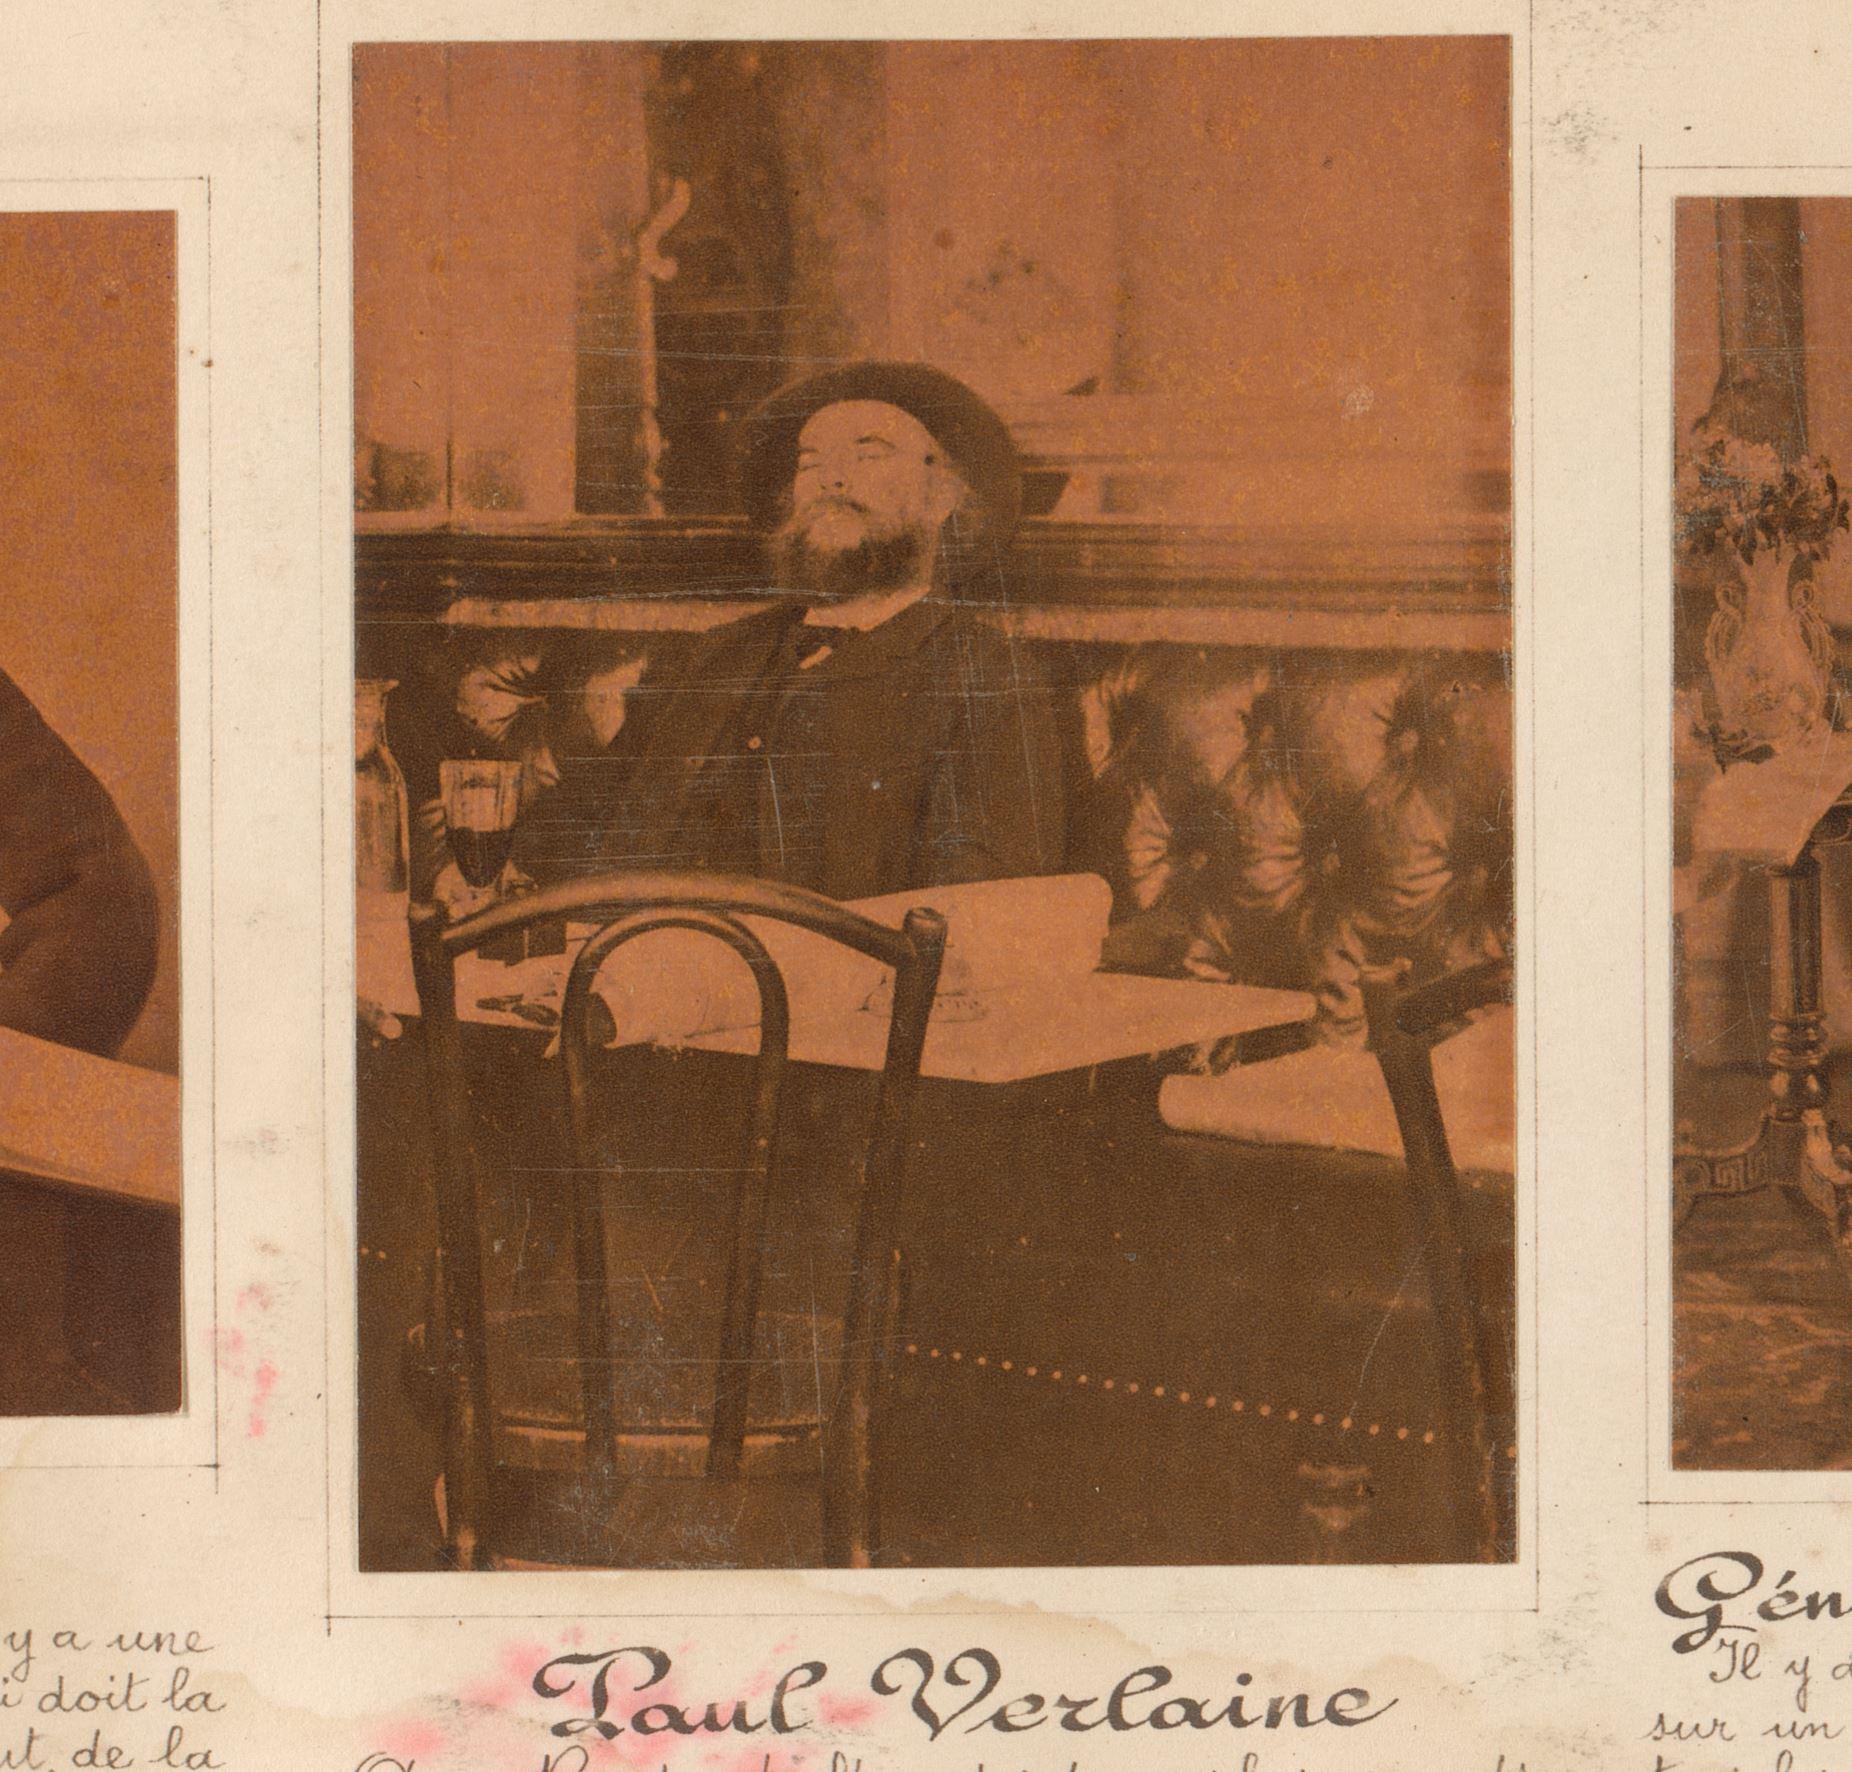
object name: photomechanical print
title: Portret van Paul Verlaine in een café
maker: Anonymous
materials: paper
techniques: rotogravure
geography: france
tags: paul verlaine, writer, poet, author, france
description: Deze prent maakt deel uit van een album.